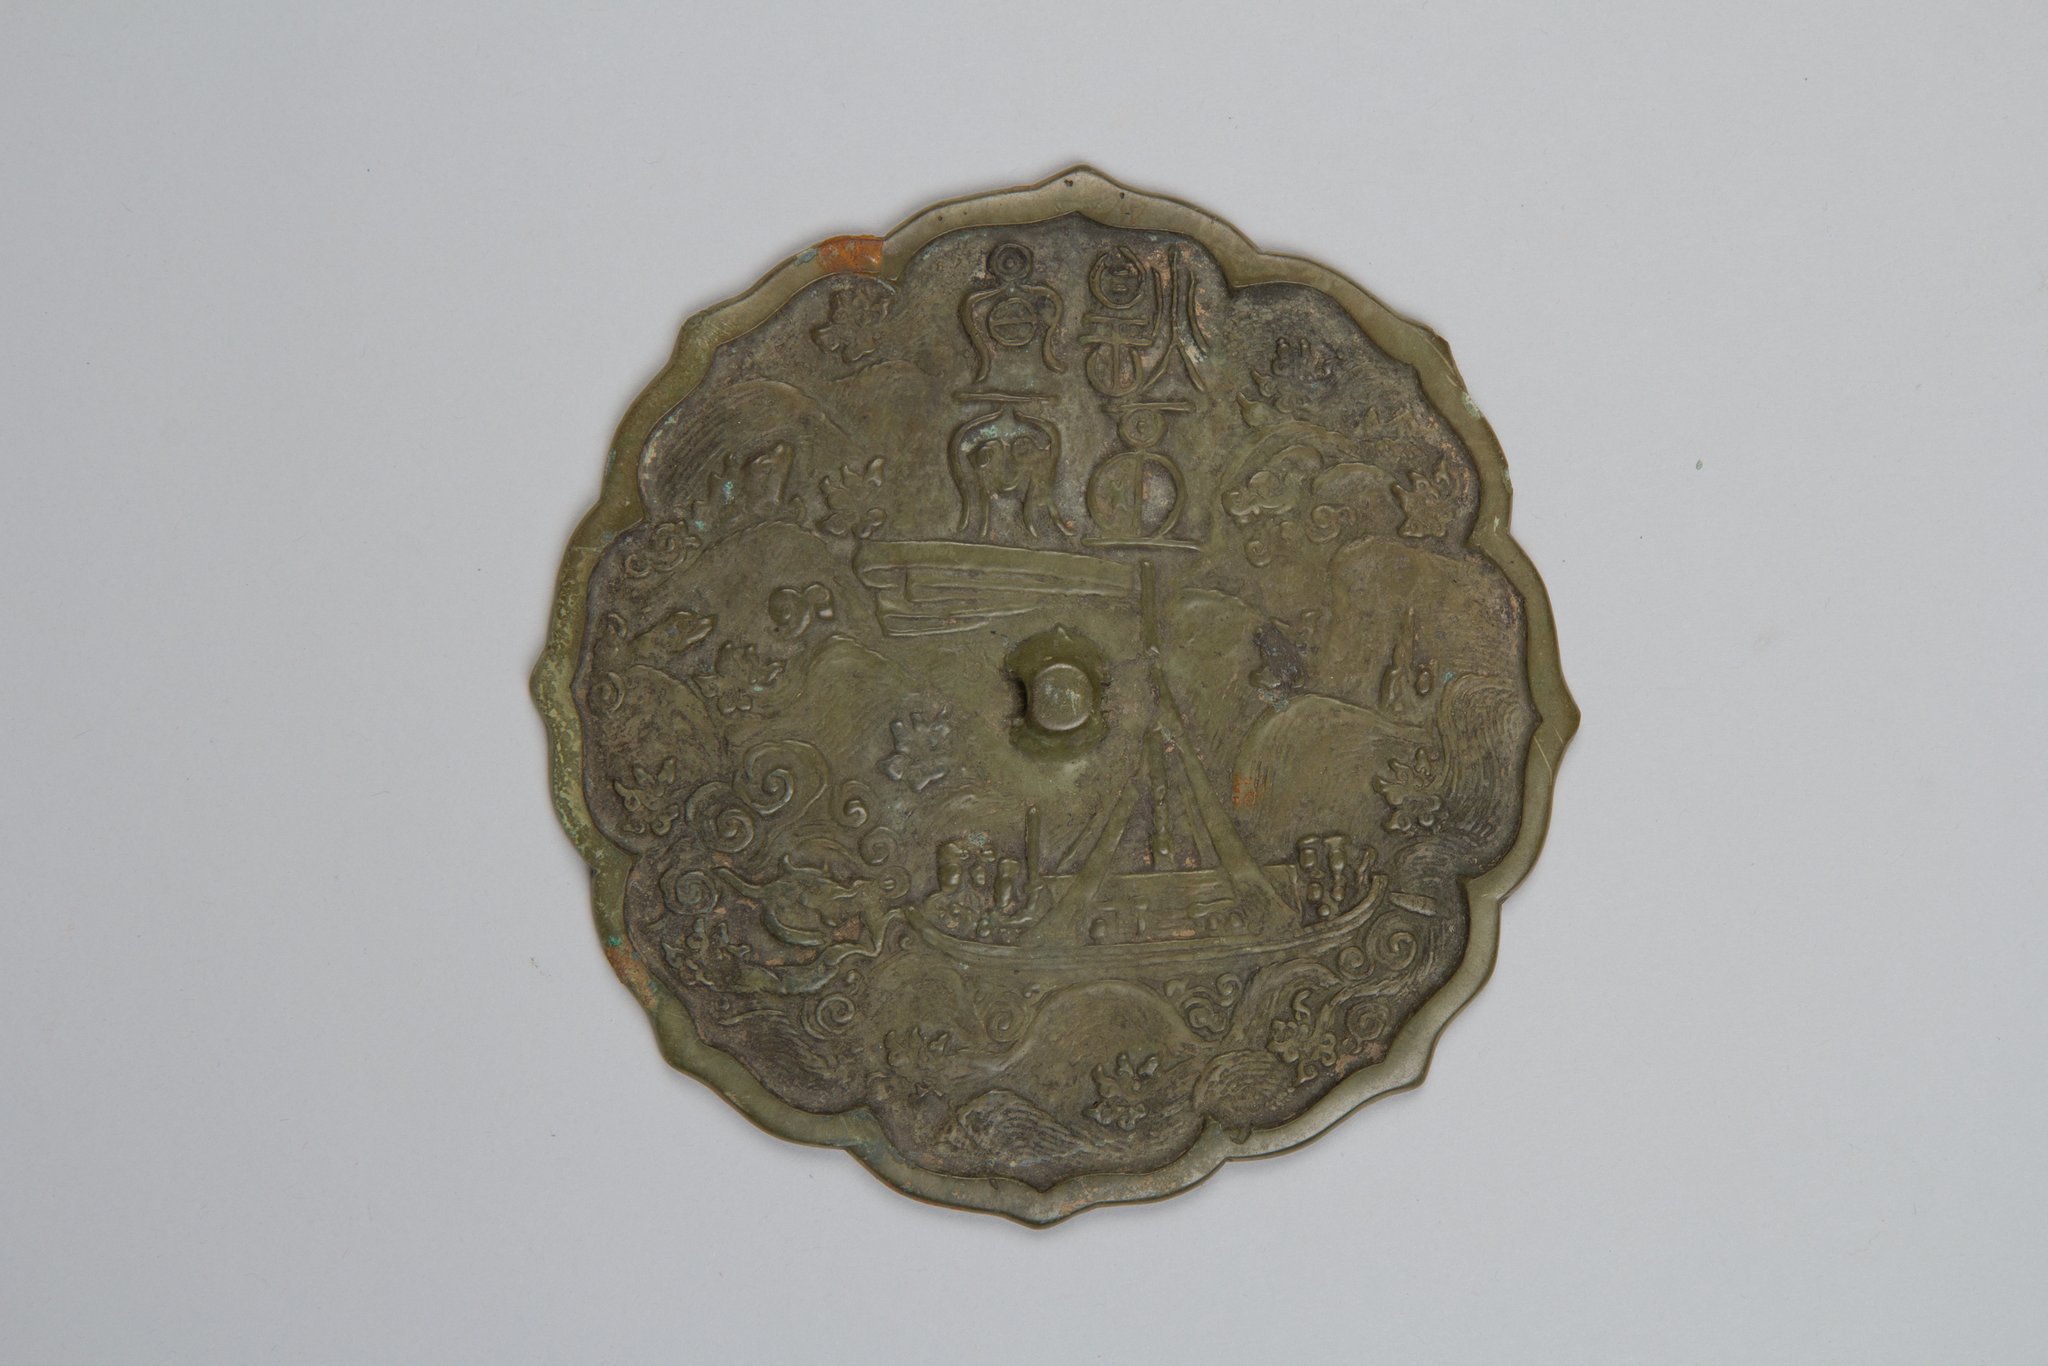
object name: mirror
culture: korean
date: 918-1392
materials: bronze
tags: boats